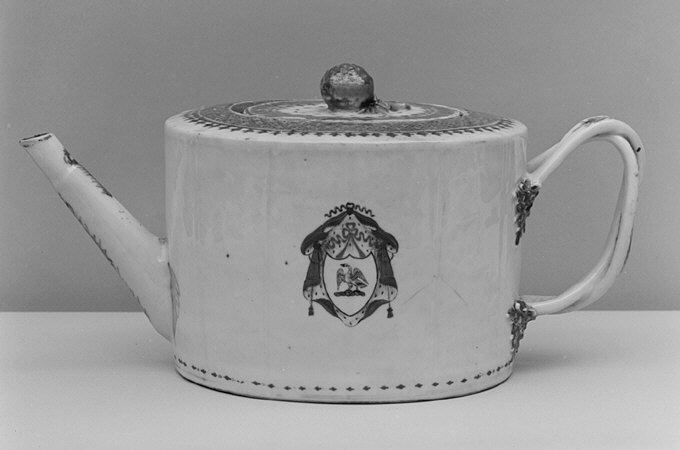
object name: teapot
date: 1767-1800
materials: hard paste porcelain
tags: coat of arms